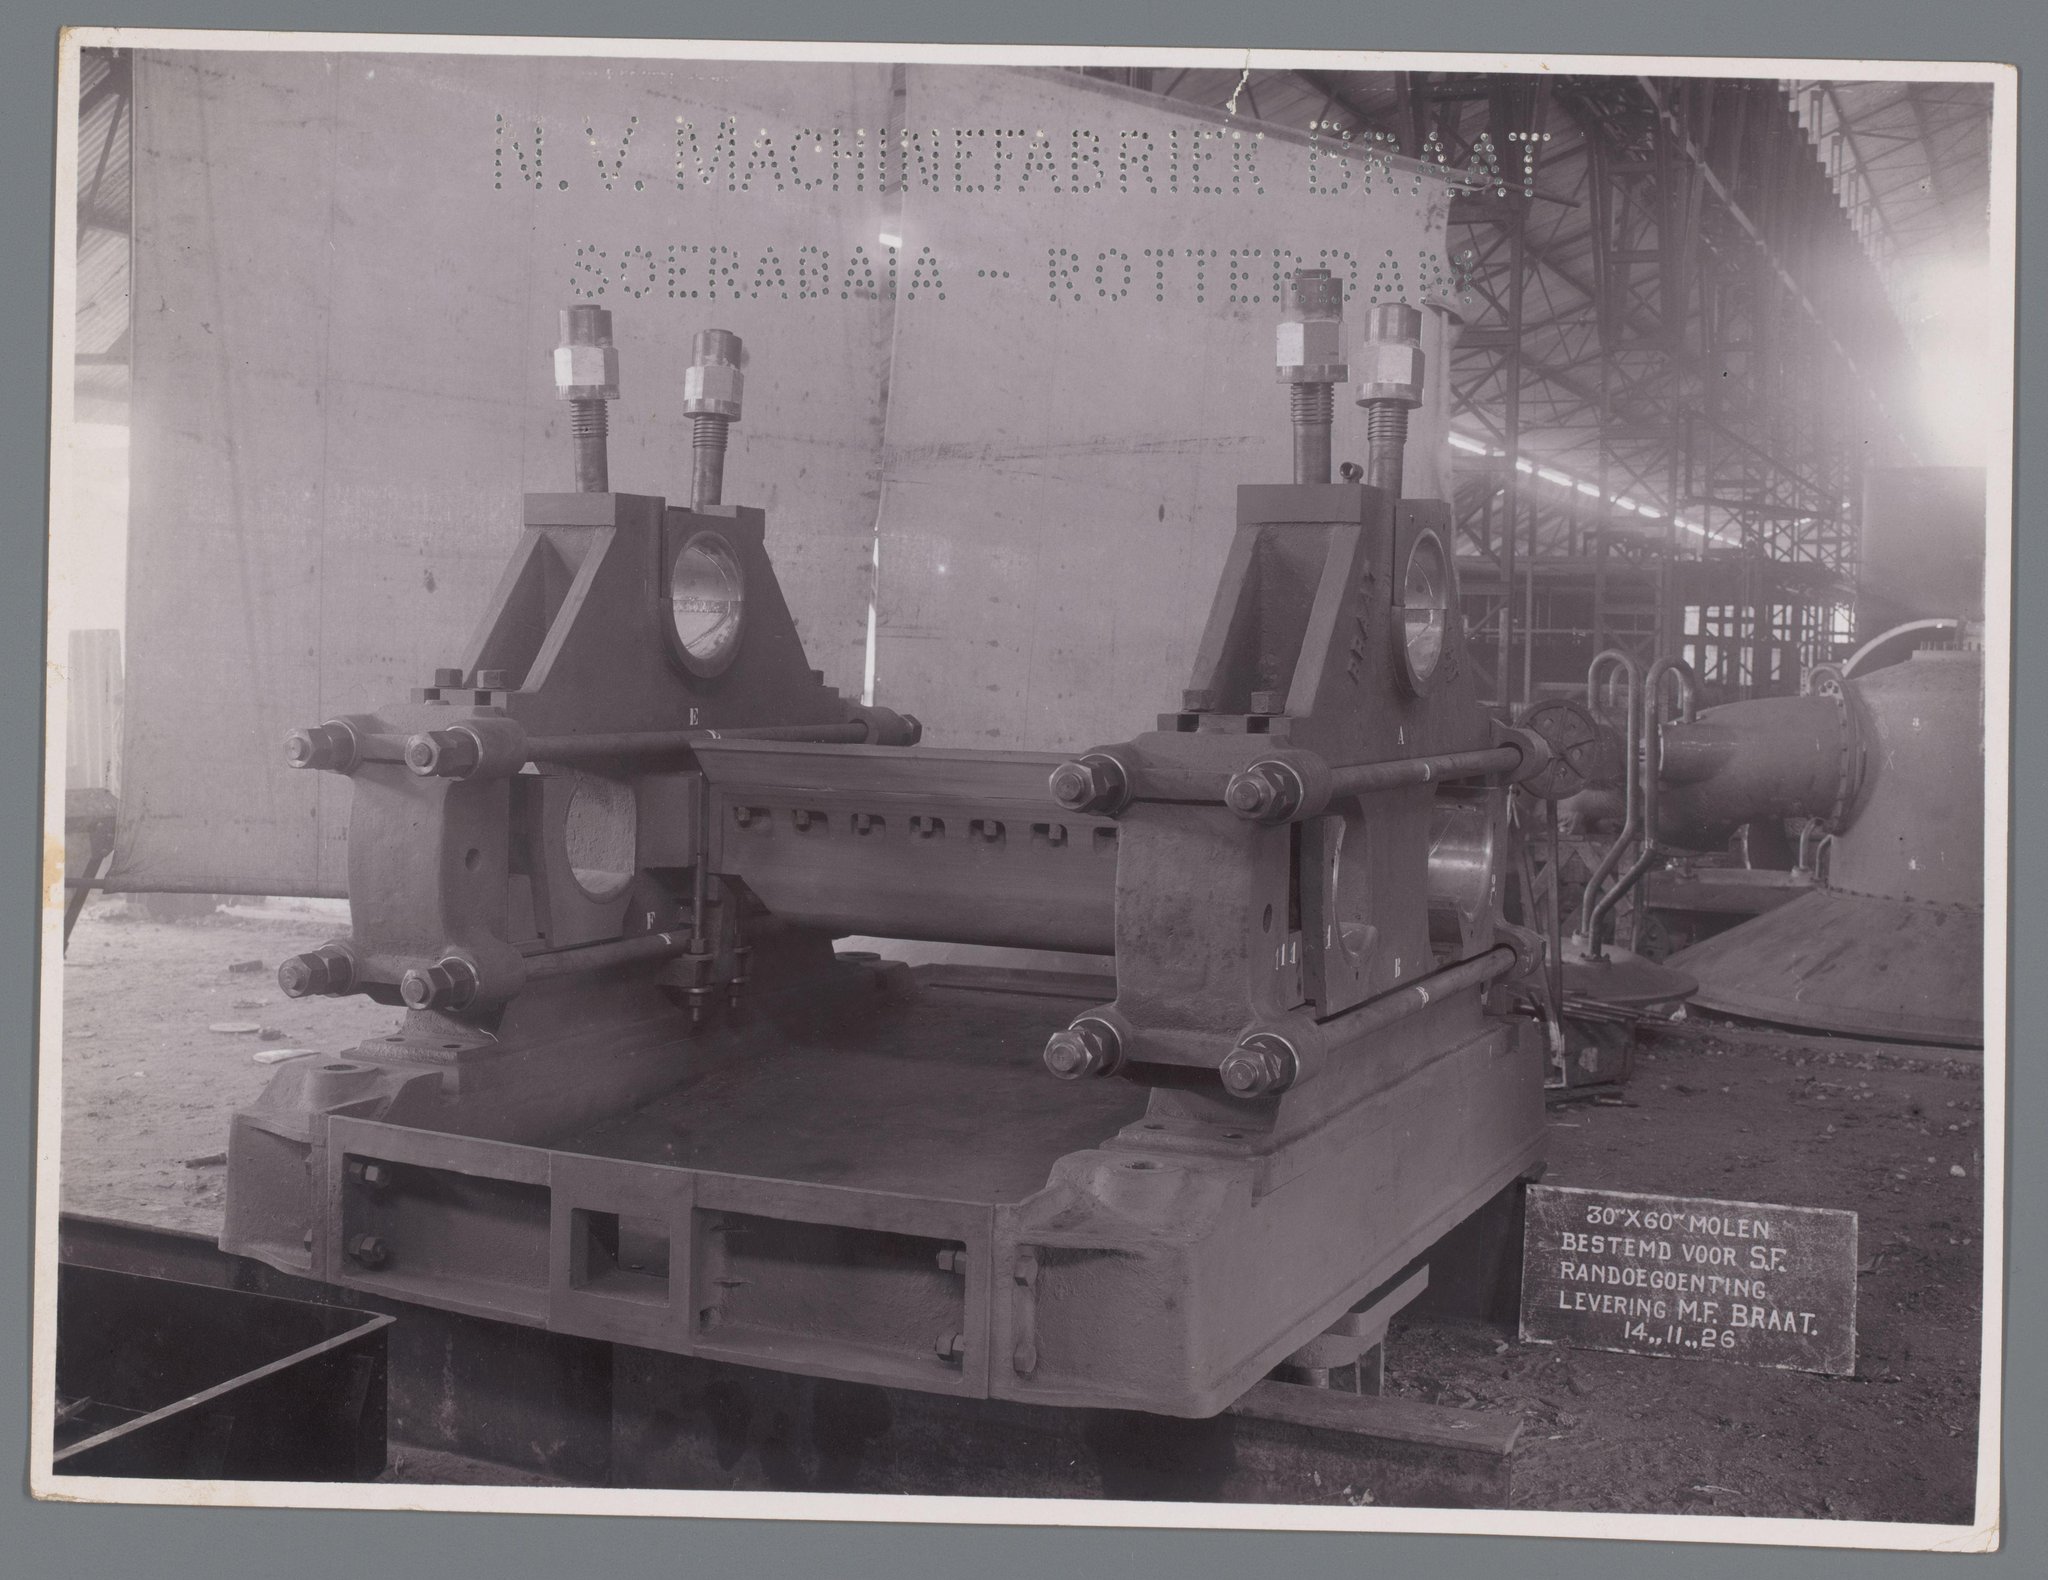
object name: photograph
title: Molen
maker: Anonymous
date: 1926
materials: photographic support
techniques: gelatin silver print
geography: surabaya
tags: colonial system, factory-interior, machine shop, machines; parts of machines; tools and appliances, java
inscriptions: company name: ‘N.V. Machinefabriek Braat / Soerabaia – Rotterdam’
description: Molen vervaardigd in 1926 en bestemd voor Suikerfabriek Randoegoenting bij Jogyakarta. Onderdeel van de multomap met foto's van machines van de N.V. Machinefabriek Braat te Soerabaja, Soekaboemi en Jogyakarta, uit de periode 1908-1942.